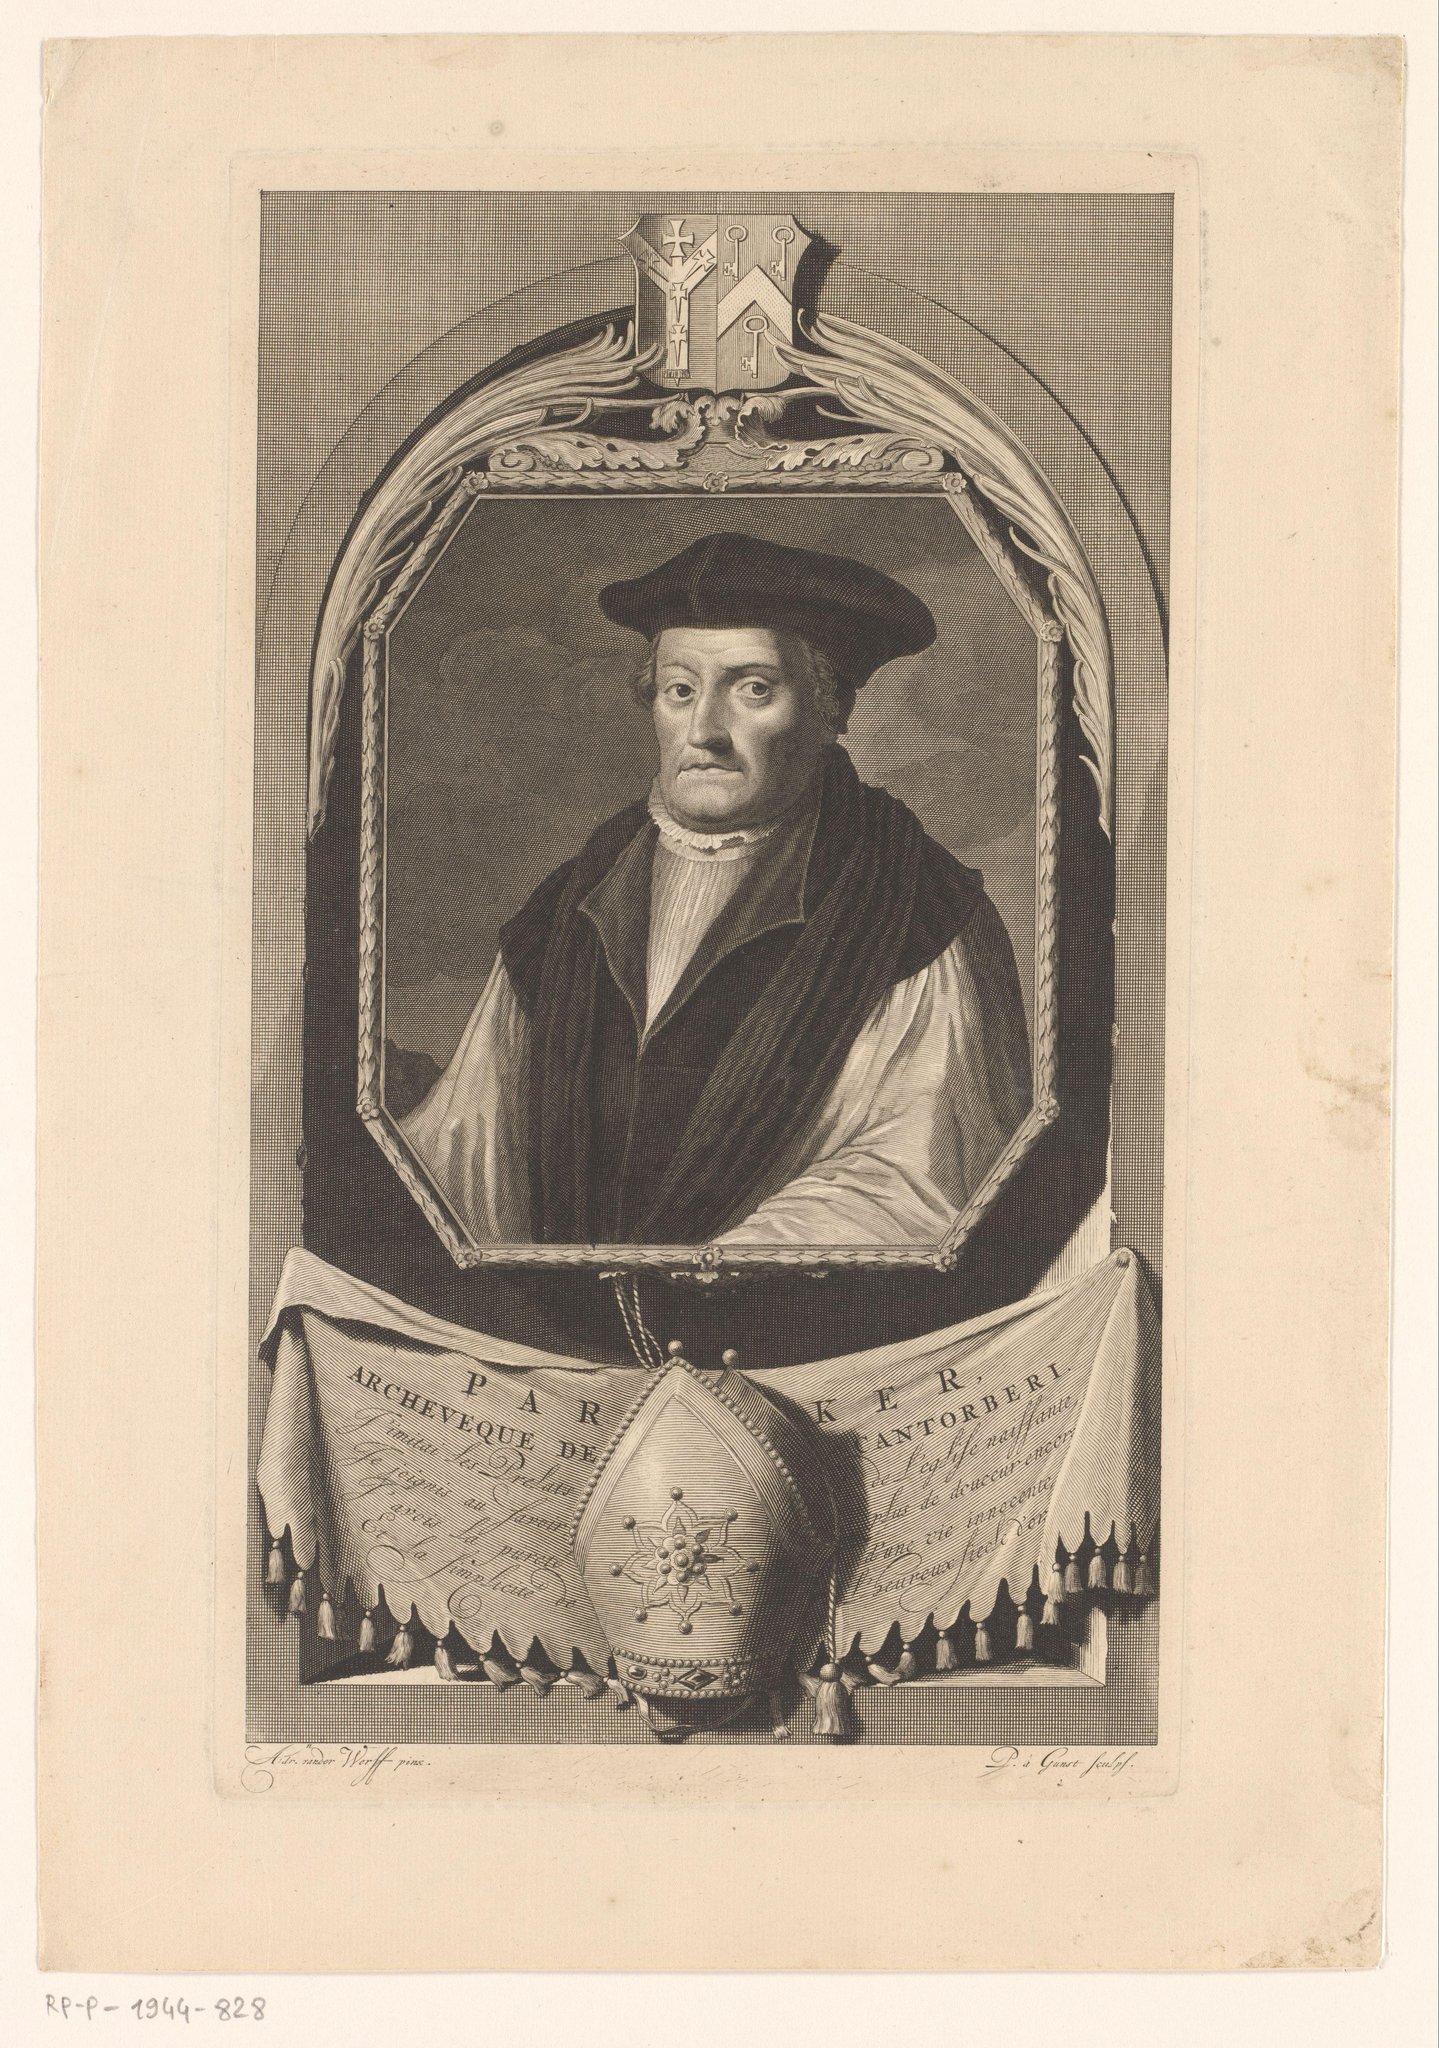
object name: print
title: Portret van Mathew Parker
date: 1698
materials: paper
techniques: engraving, etching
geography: amsterdam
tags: archbishop, bishop, etc. (roman catholic), insignia of bishop, e.g. mitre, crozier, historical persons, armorial bearing, heraldry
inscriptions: collector's mark: Lugt 2228, inscription: ‘in Franken aanwezig/ Gm’